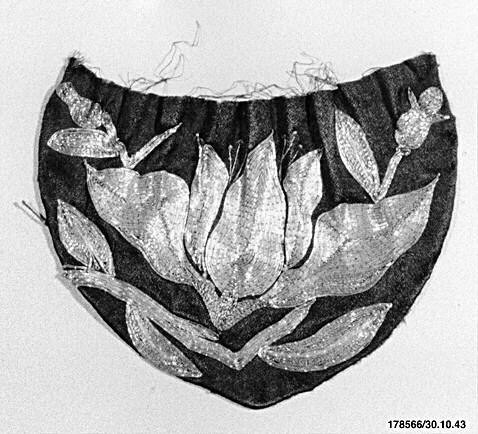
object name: coin purse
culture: chinese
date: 1801-1900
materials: metal thread, silk